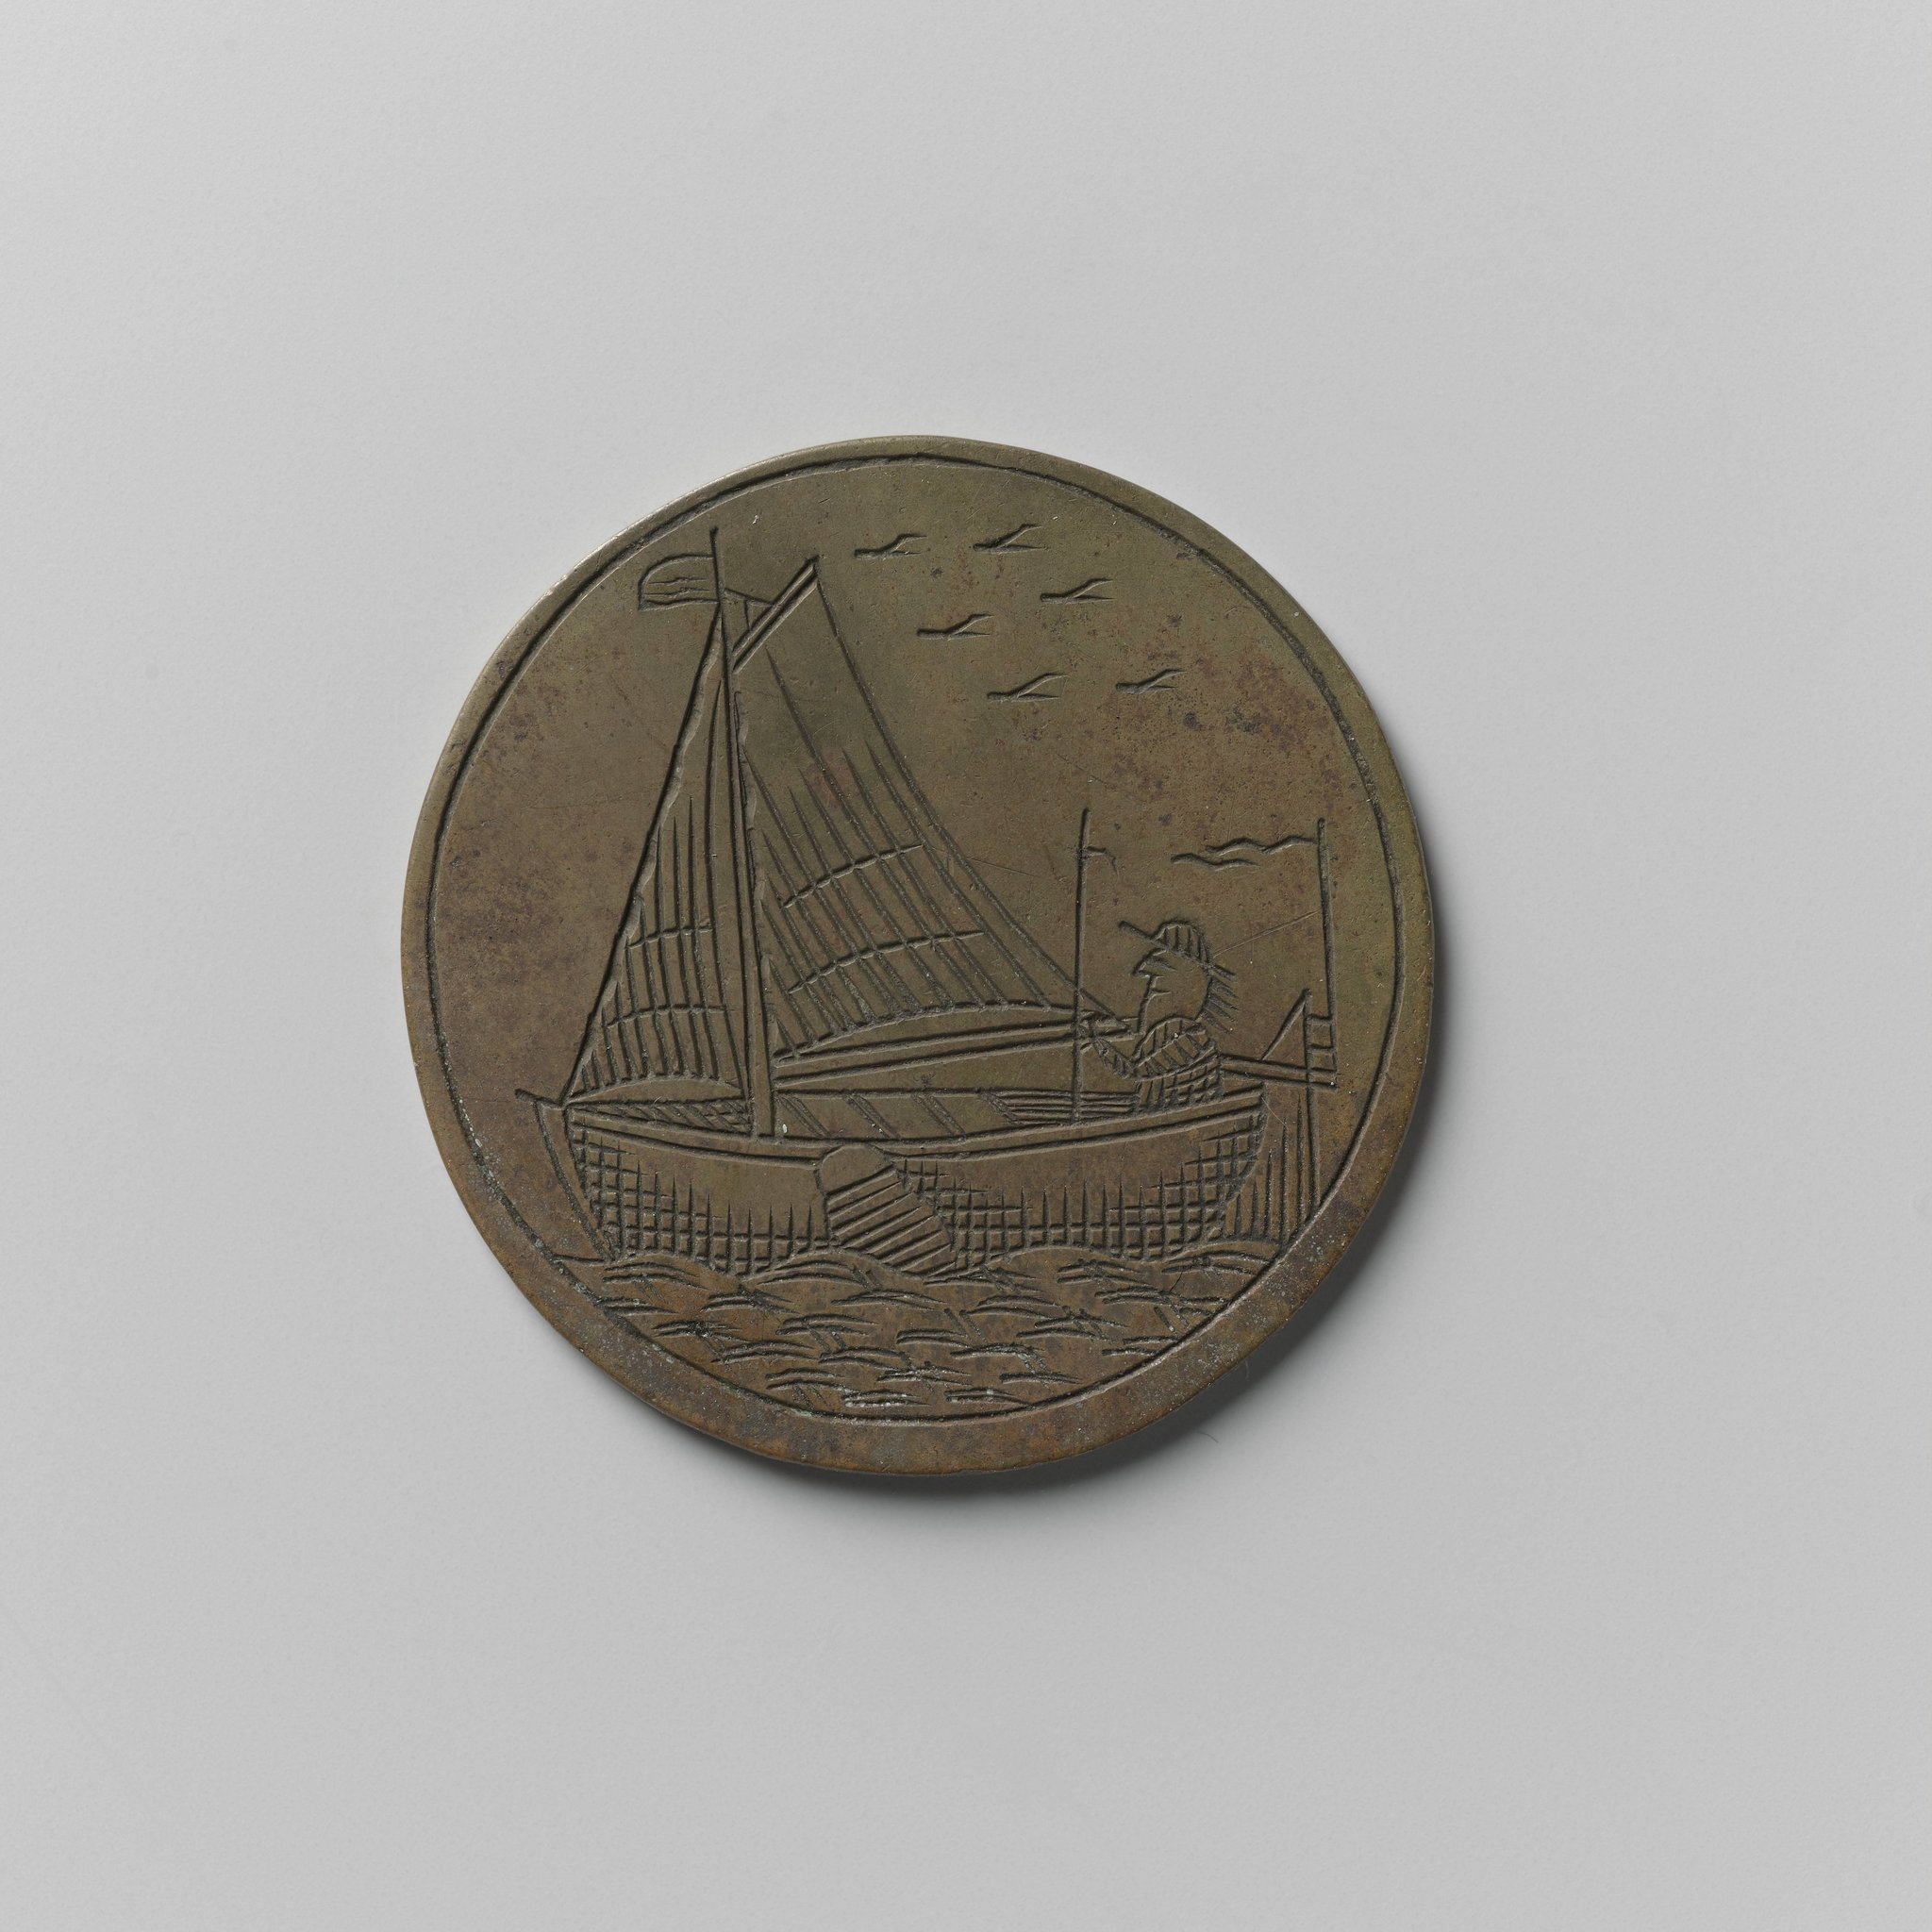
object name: medal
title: Roei-, steiger- en schuitenvoerdersgilde van Amsterdam, gildepenning van Jan Koops, ligplaats Nieuwe Brug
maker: Anonymous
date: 1749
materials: brass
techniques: engraving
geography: amsterdam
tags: amsterdam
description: Messing penning. Voorzijde: naar links varende zeilboot; op achterplecht: zittende man en vlag. Keerzijde: opschrift boven huismerk en hart met daarin letters J en K tussen monogram van letters N en B